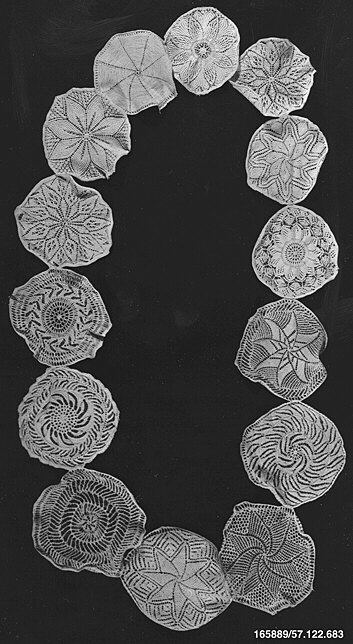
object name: sampler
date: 1801-1900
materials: lace, wool